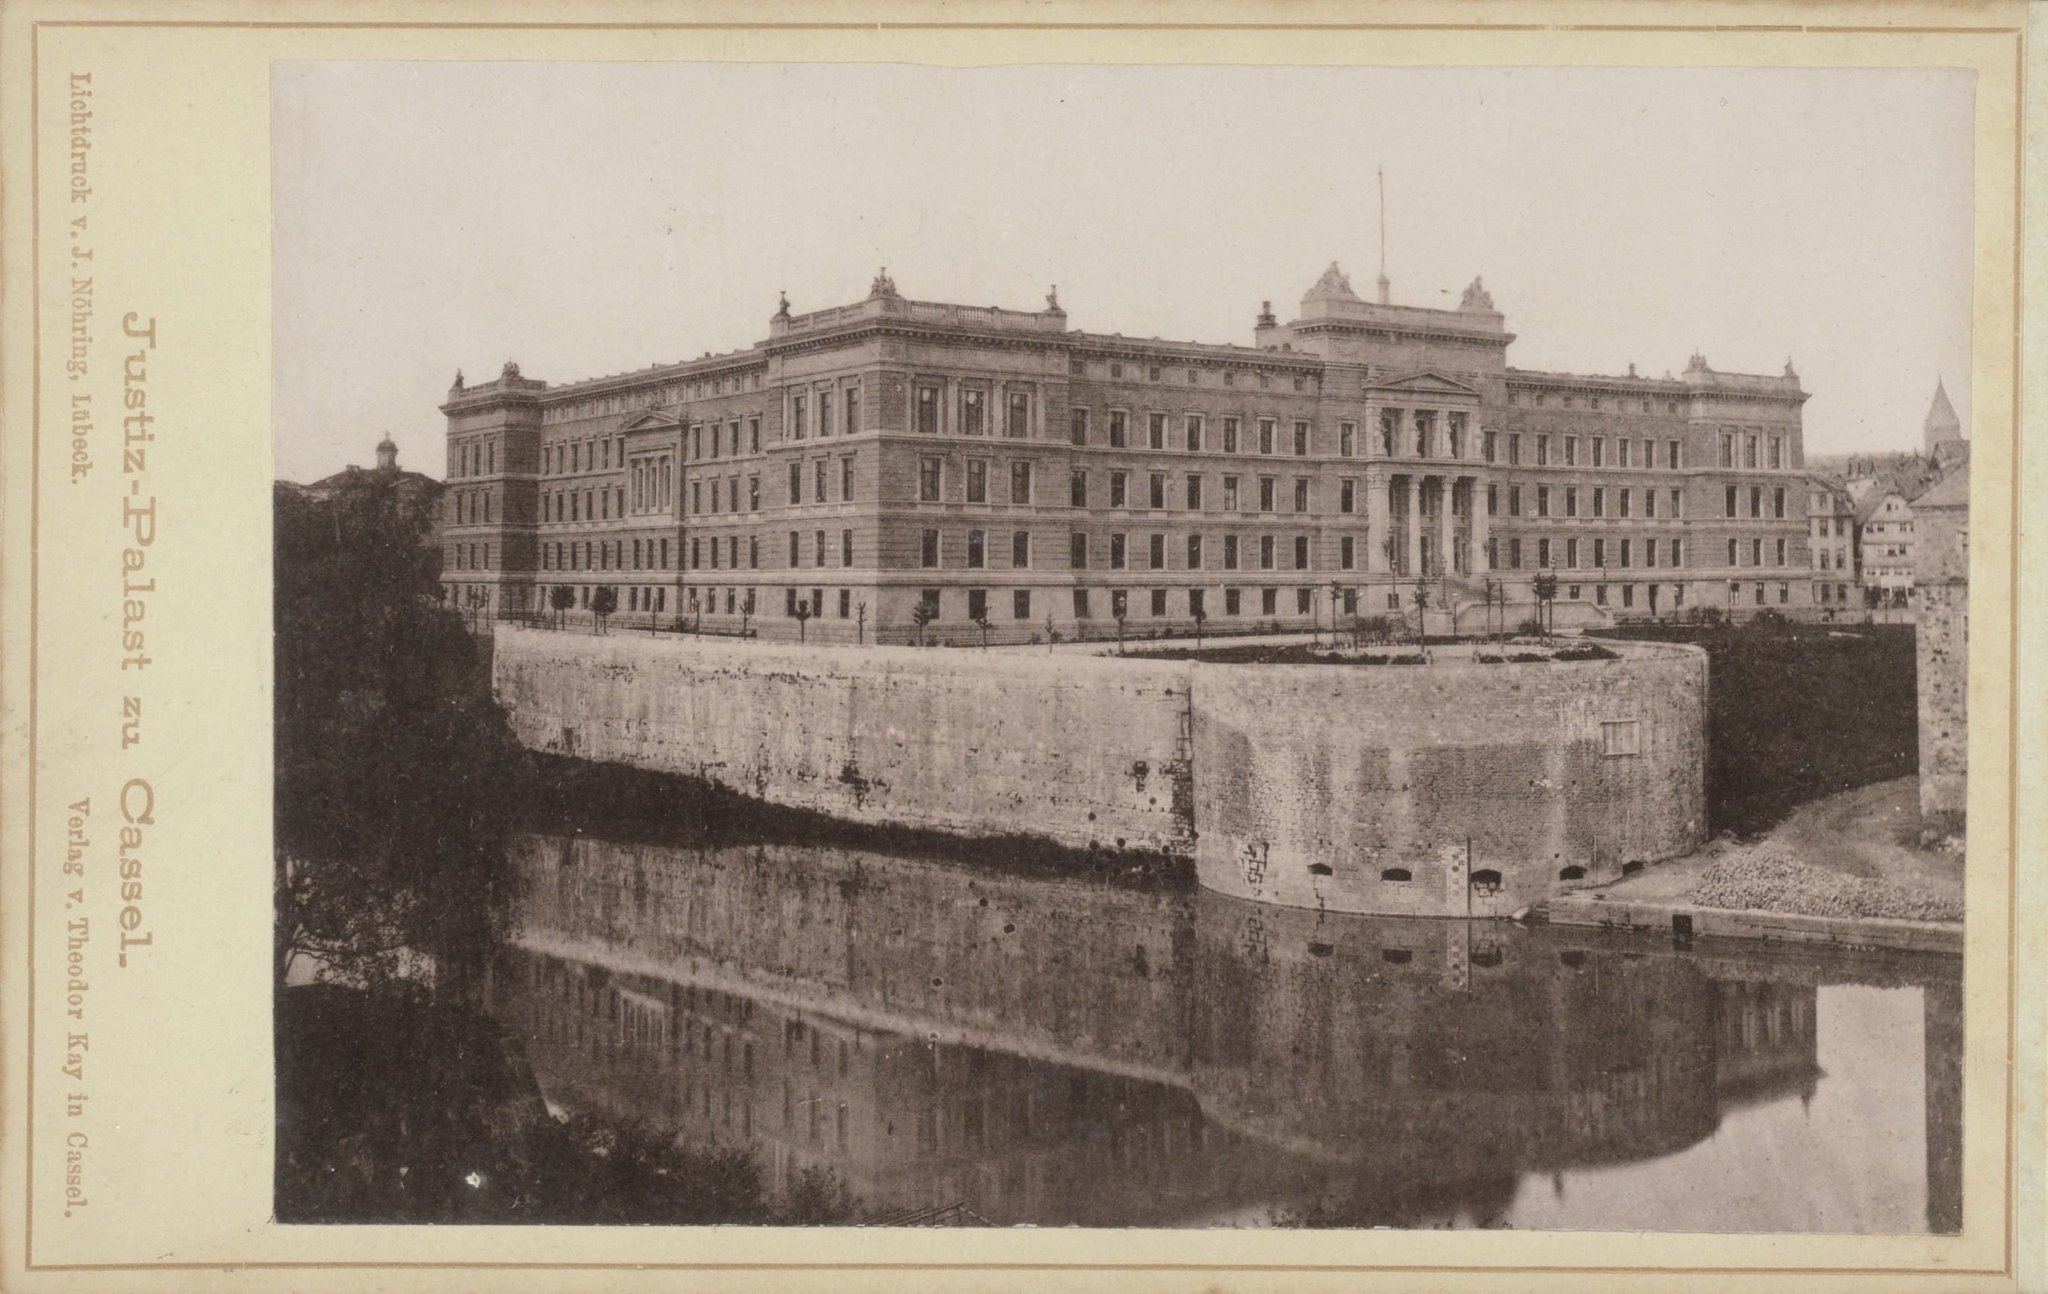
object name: photograph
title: Exterieur van het Paleis van Justitie in Kassel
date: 1870-1890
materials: cardboard, paper, photographic support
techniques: photograph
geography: kassel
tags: court building, travelling; tourism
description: Onderdeel van Album met 38 foto's van een reis door de Harz.